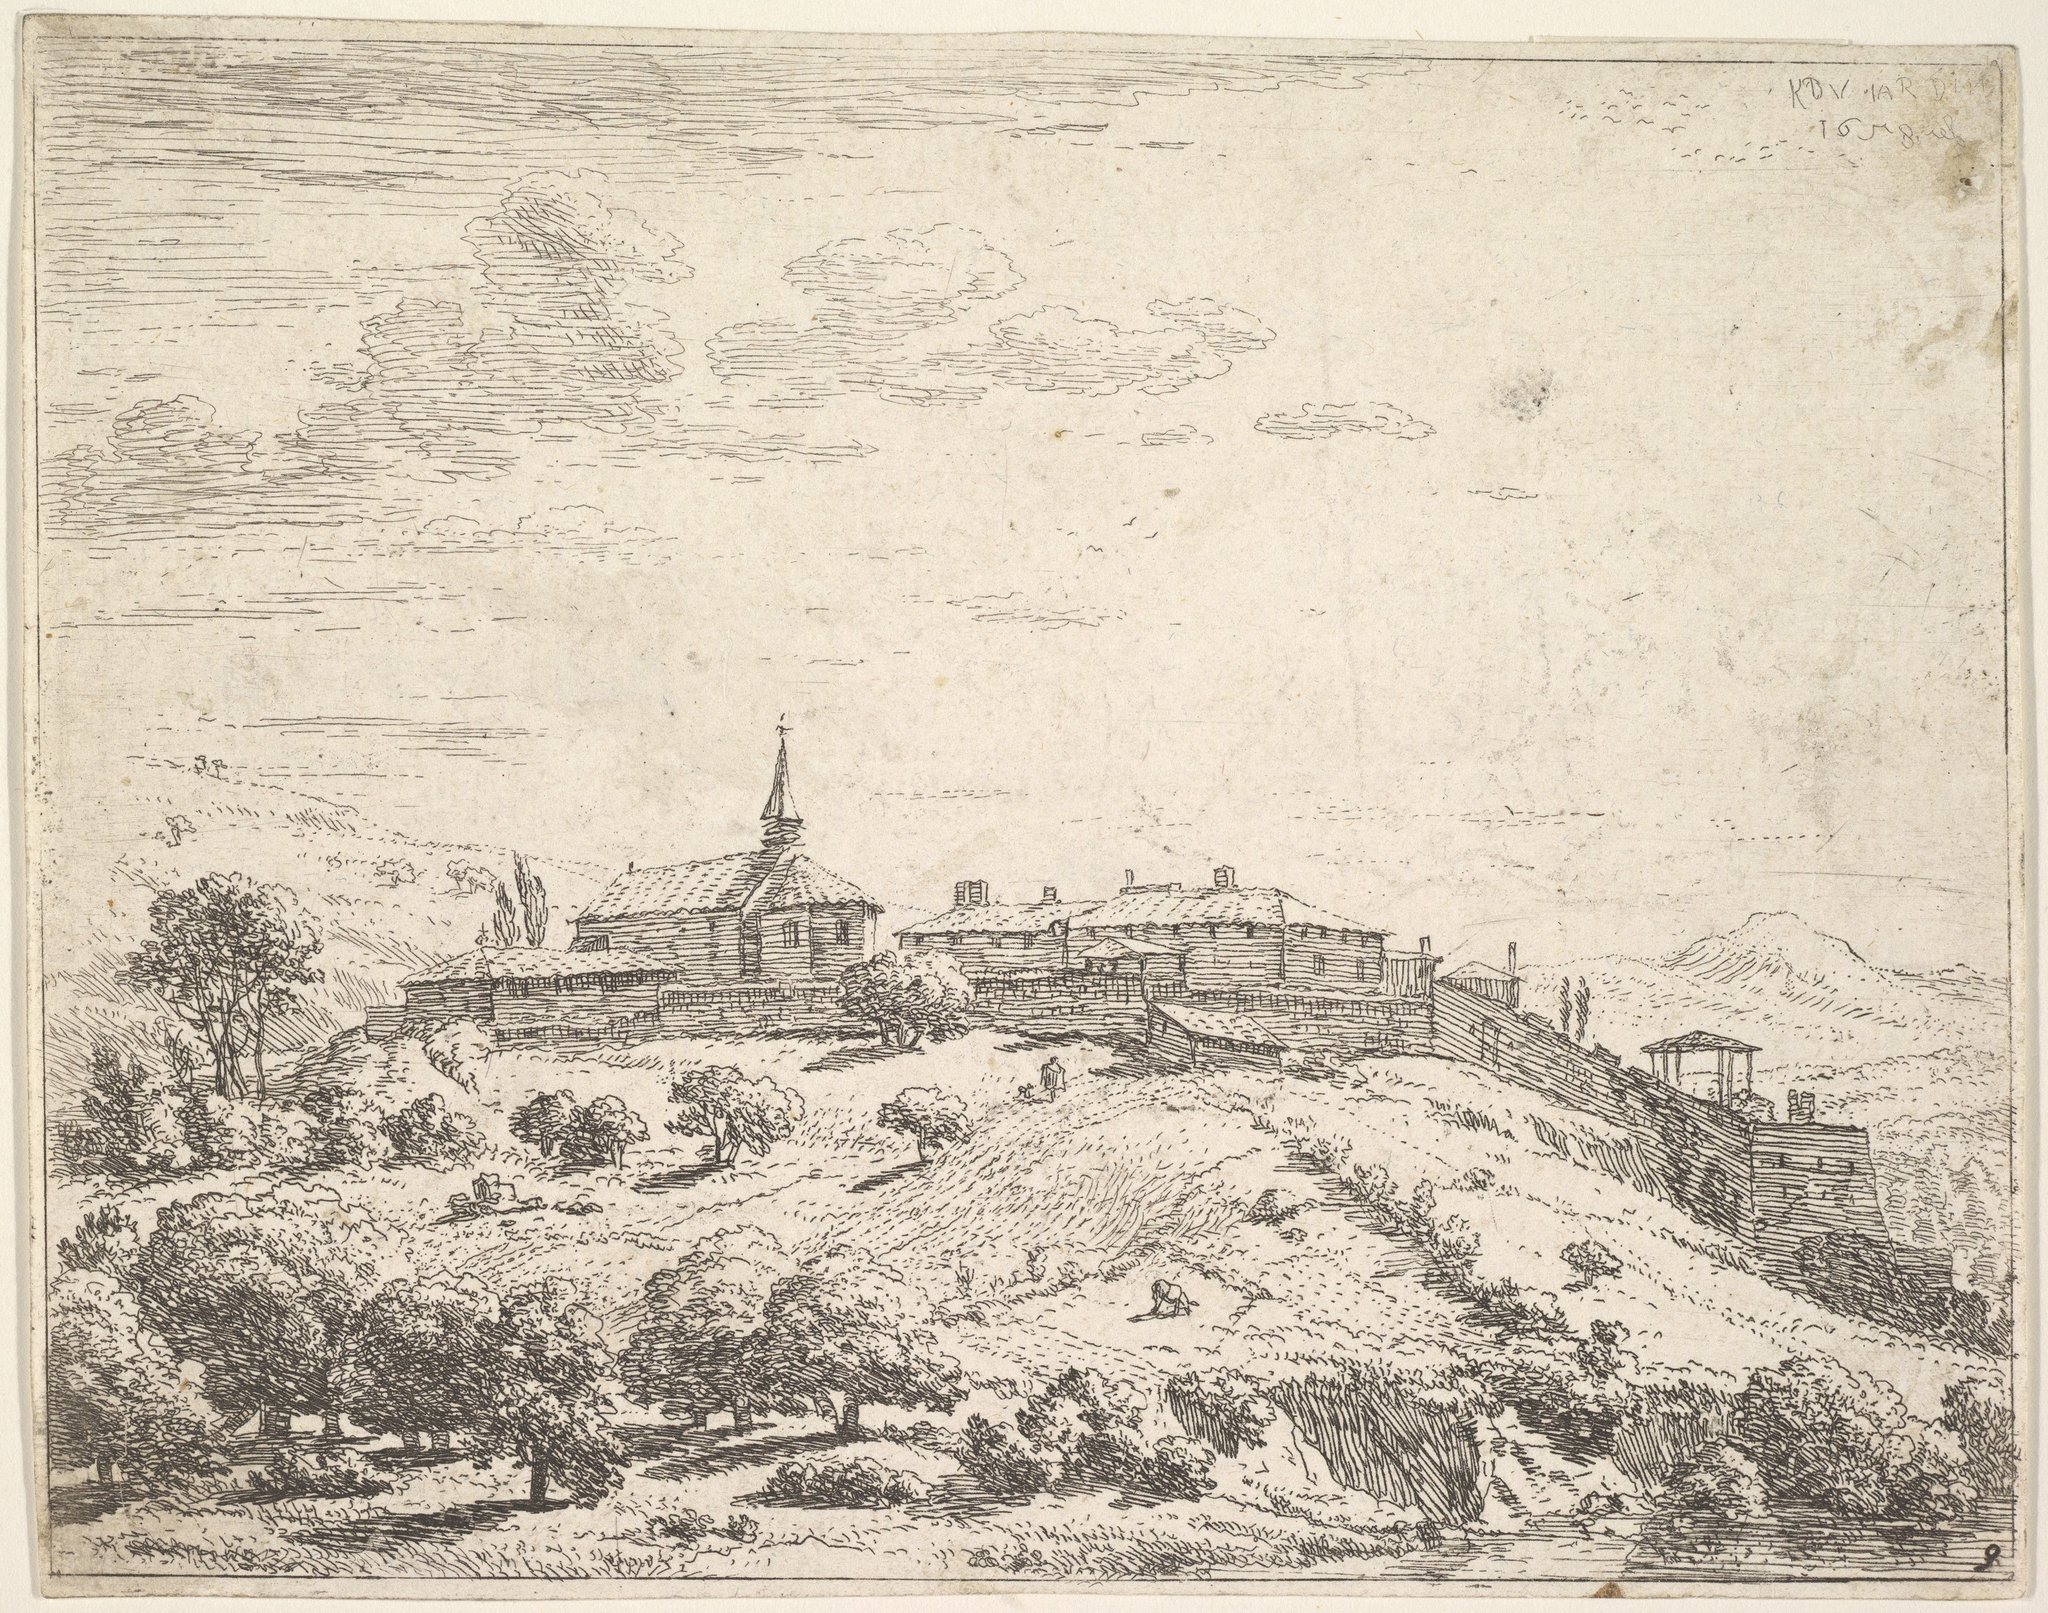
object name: print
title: Walled village on a hill, with church at left and buildings constructed on the downslope at right, trees and hillside in the foreground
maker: karel dujardin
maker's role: artist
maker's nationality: dutch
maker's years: 1622-1678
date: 1658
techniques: etching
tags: buildings,churches,villages,hills,trees